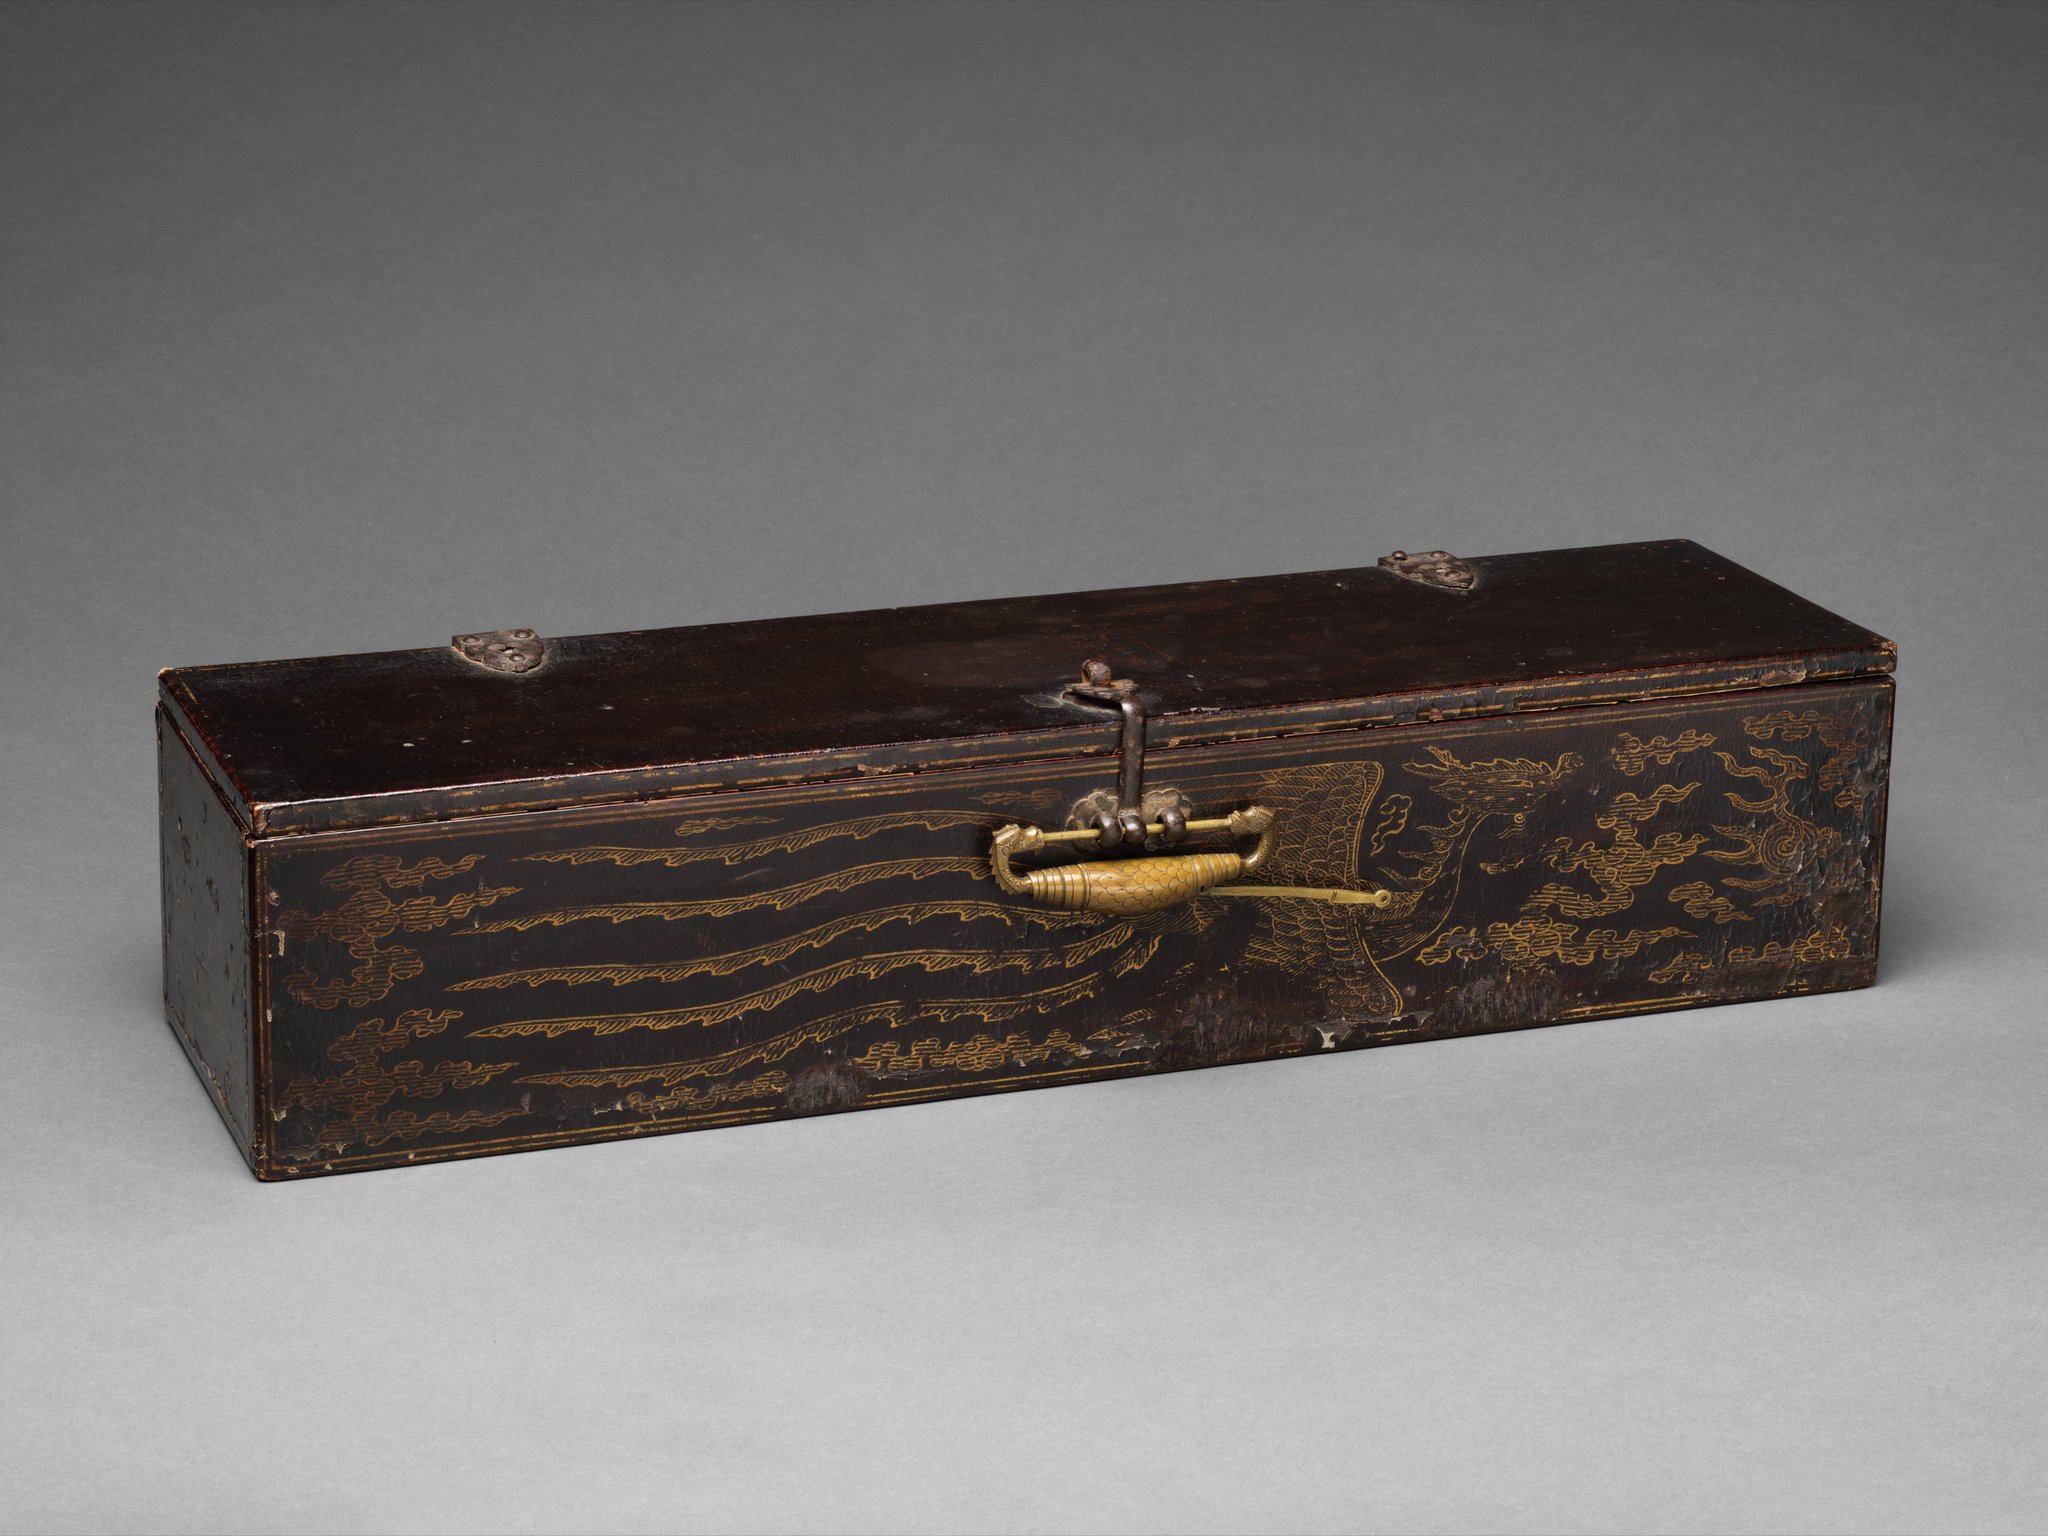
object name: box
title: Black lacquer box with phoenix designs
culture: korean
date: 1701-1900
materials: gold paint, lacquer, metal